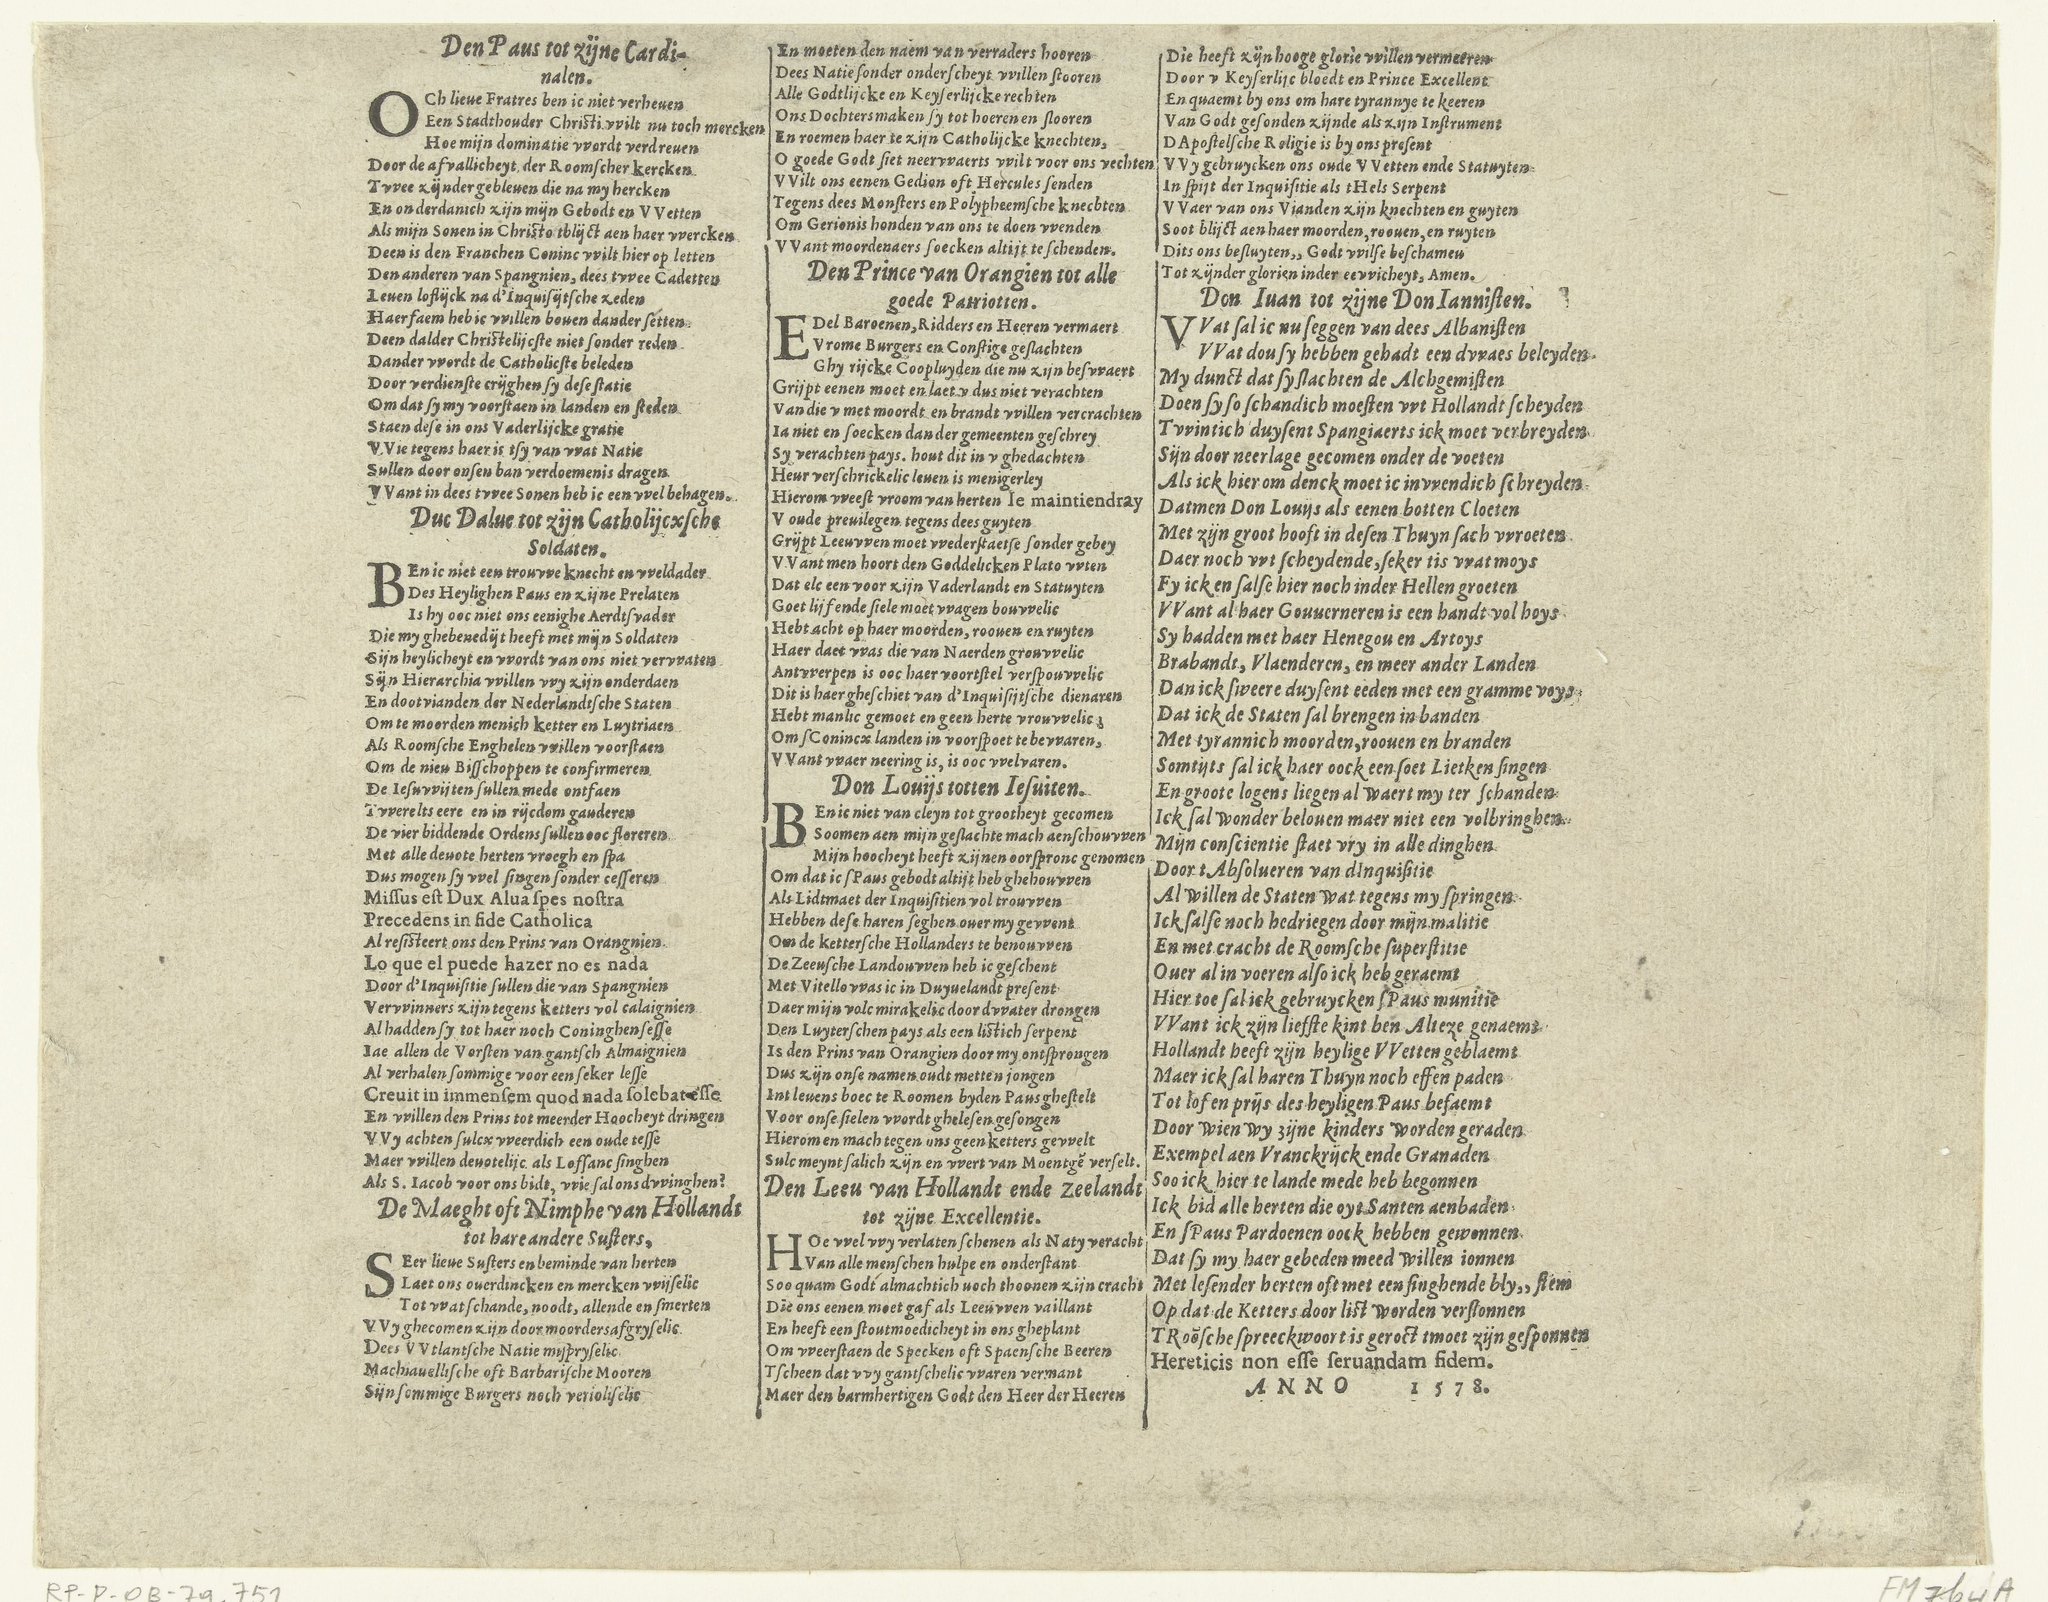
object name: text sheet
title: Tekstblad behorend bij een onbekende spotprent op Don Juan, 1578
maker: Anonymous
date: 1578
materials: paper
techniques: letterpress printing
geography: low countries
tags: delft, william i (prince of orange), fernando álvarez de toledo (3rd duke of alba), brussels, mayor, luis de zúñiga y requesens, don juan van oostenrijk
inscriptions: date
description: Tekstblad behorend bij een onbekende spotprent op de landvoogd Don Juan van Oostenrijk en zijn voorgangers, 1578. Tekst in 3 kolommen in het Nederlands, met rollen voor de paus, de hertog van Alva, de Hollandse Maagd, de prins van Oranje, Requesens, de Hollandse Leeuw en Don Juan.